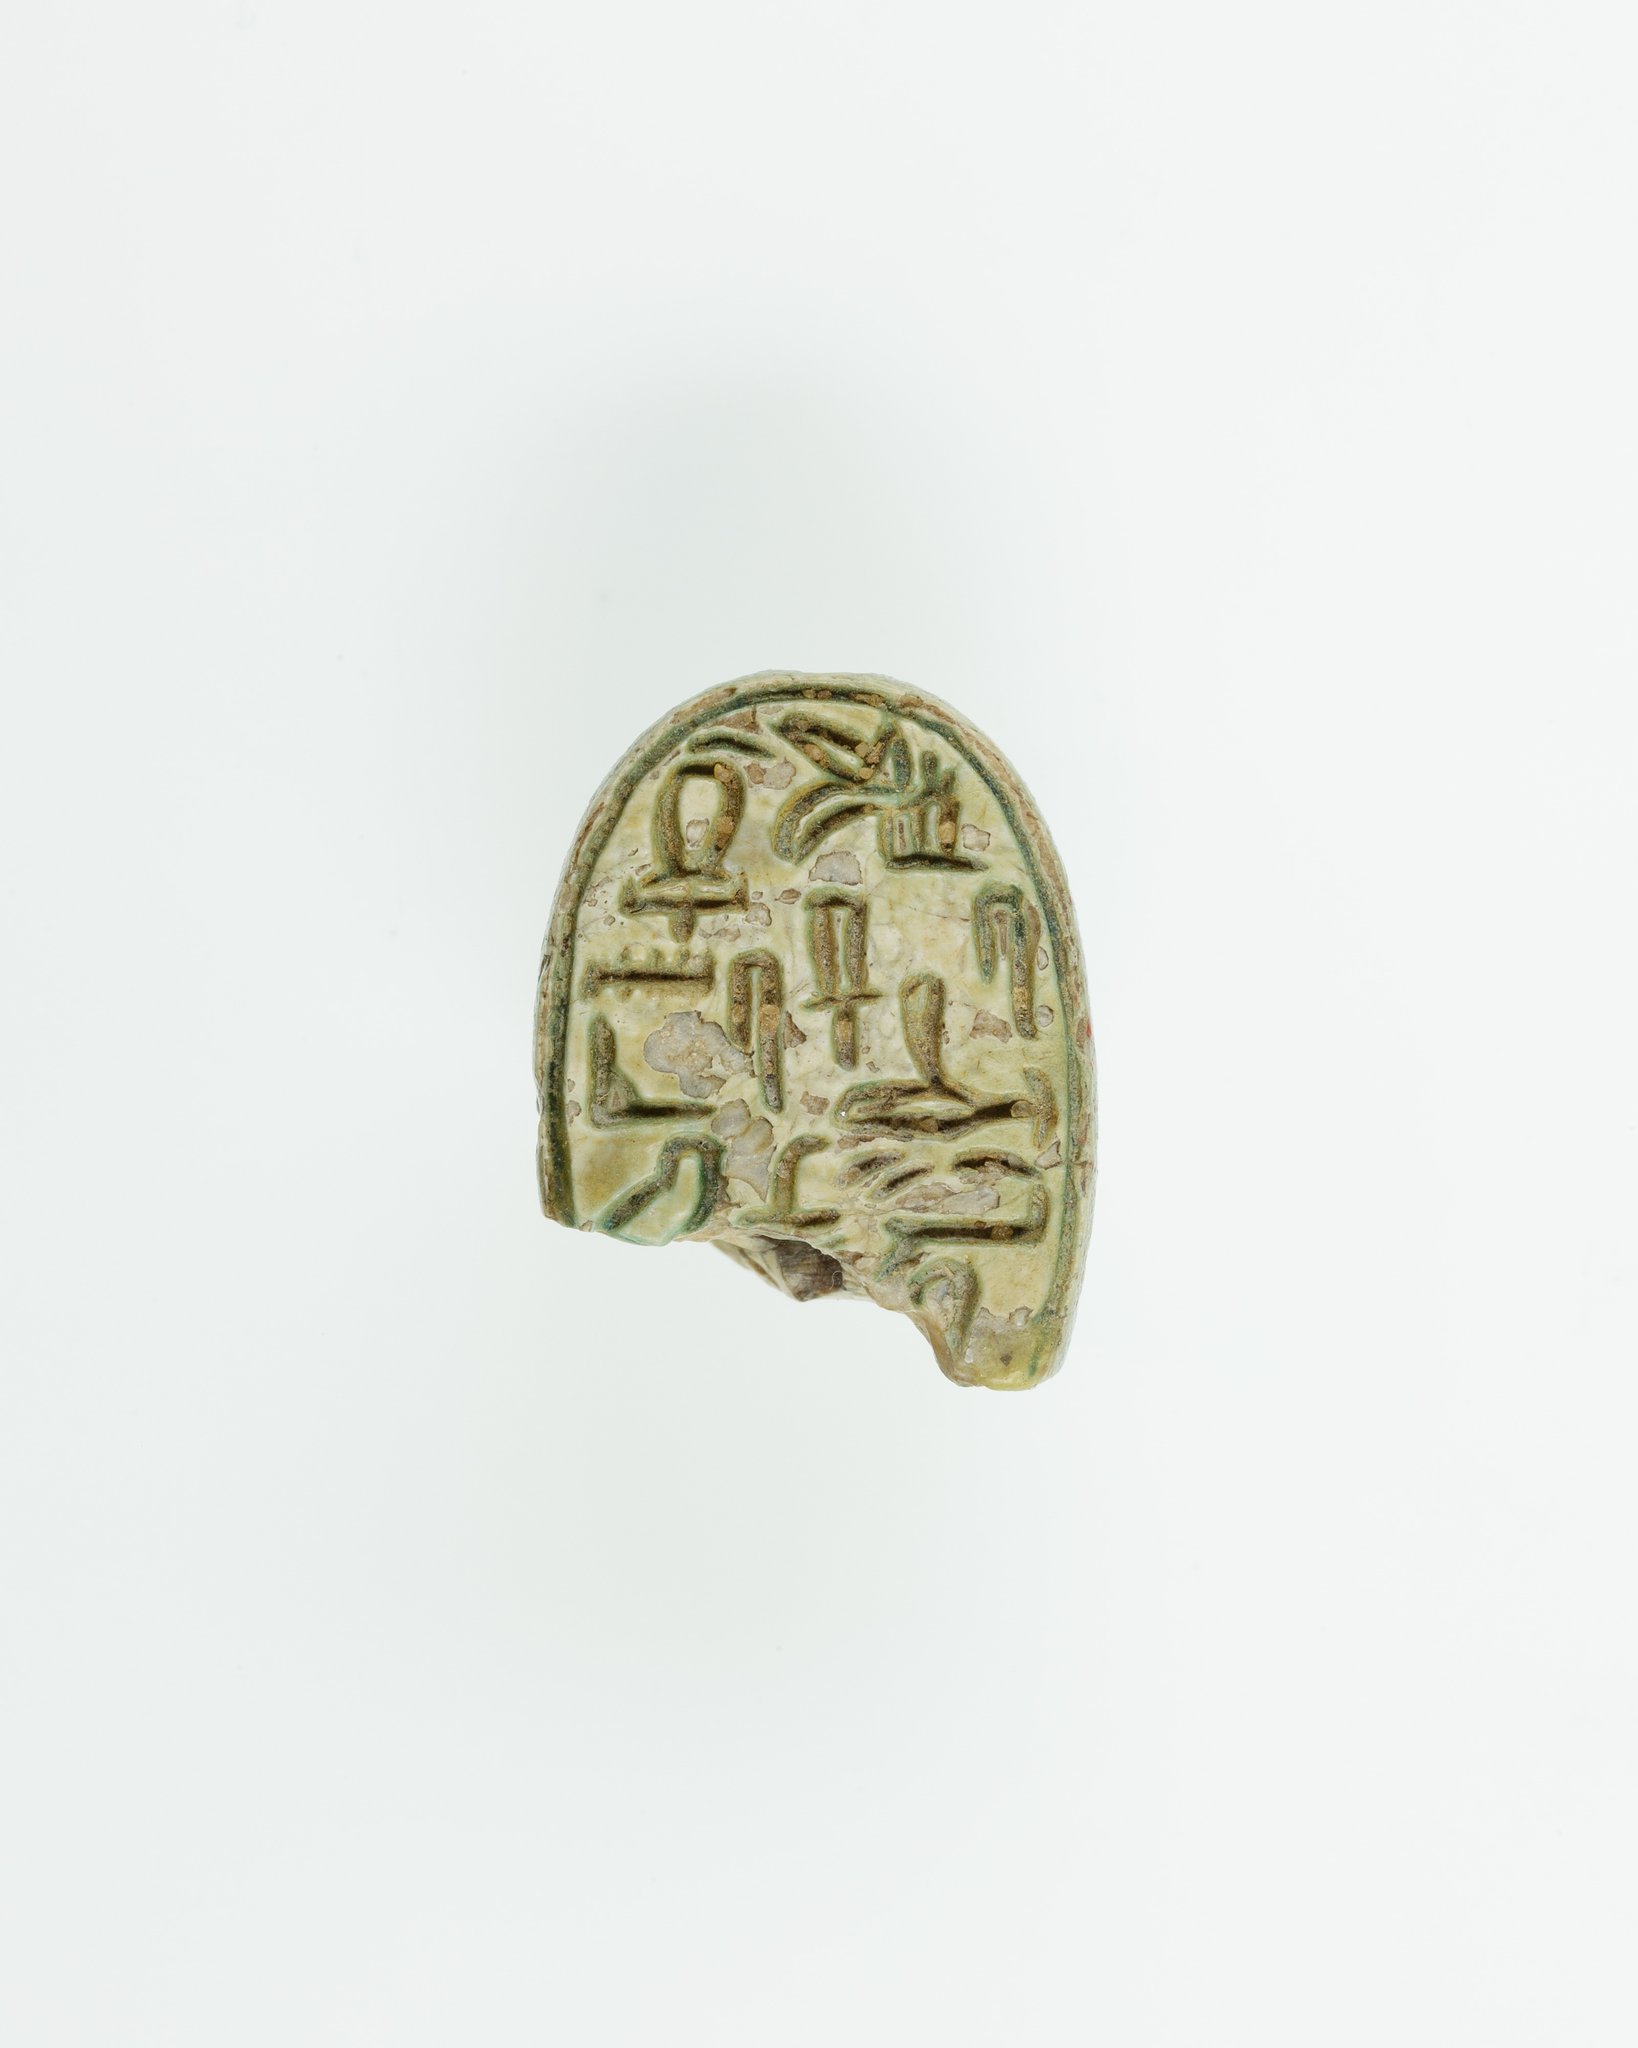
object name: scarab, official, private name and title, senebsumai, royal treasurer, sealer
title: Scarab of an Official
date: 1760-1670 BCE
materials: stone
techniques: glazing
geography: egypt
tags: hieroglyphs,scarabs